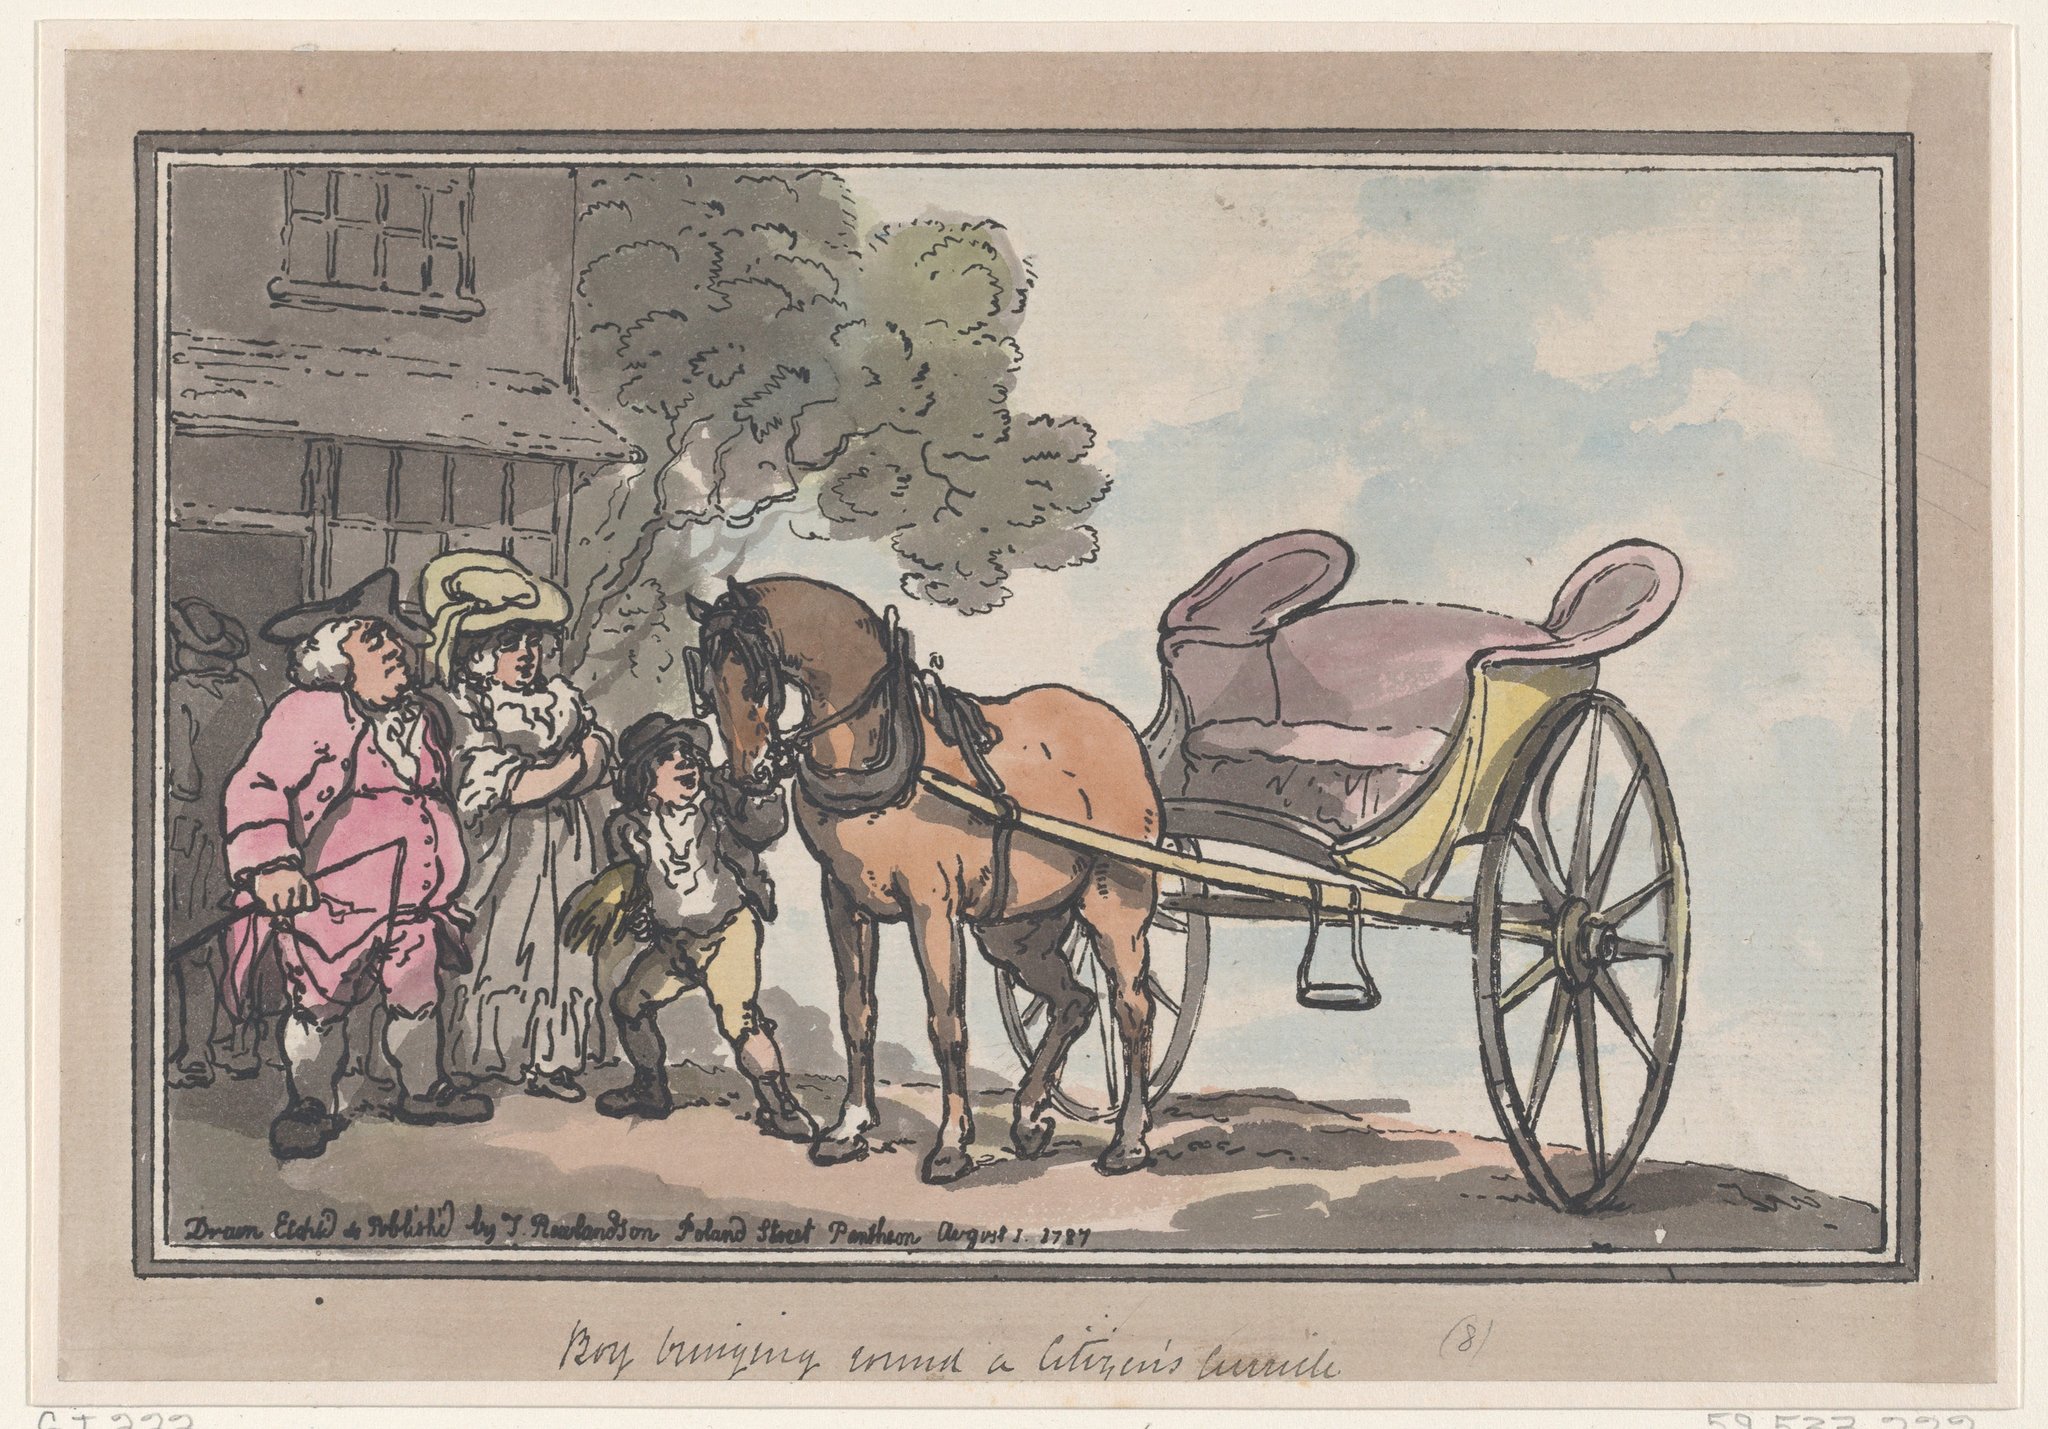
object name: print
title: Boy Bringing Round a Citizen's Curricle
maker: thomas rowlandson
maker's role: artist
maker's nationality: british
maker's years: 1757-1827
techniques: aquatint, etching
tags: men,women,horses,carriages